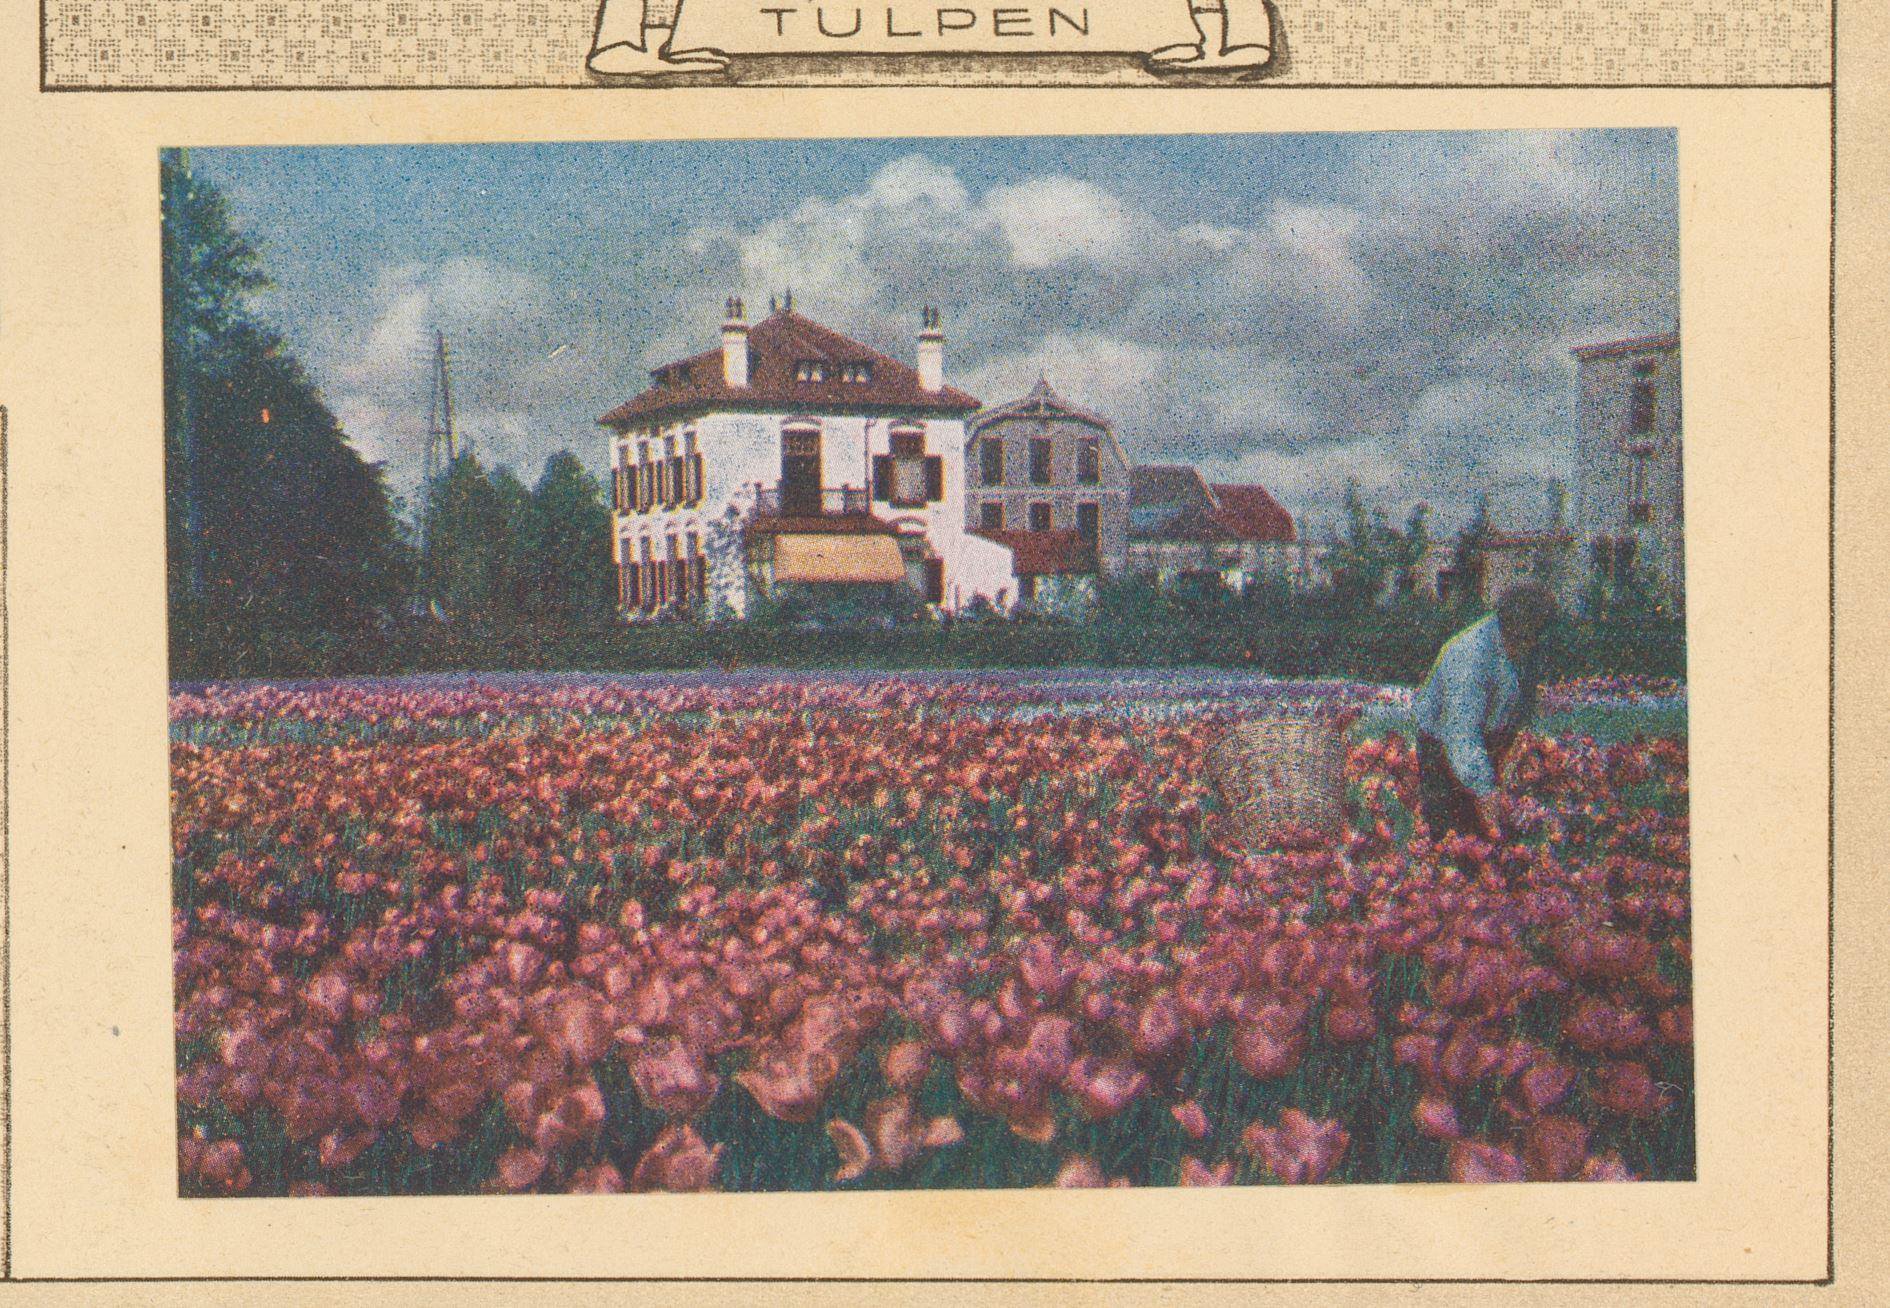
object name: photomechanical print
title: Gezicht op een tulpenveld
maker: Anonymous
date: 1915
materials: paper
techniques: rotogravure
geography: netherlands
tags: bulb field, flowers: tulip, netherlands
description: Deze prent maakt deel uit van een album.